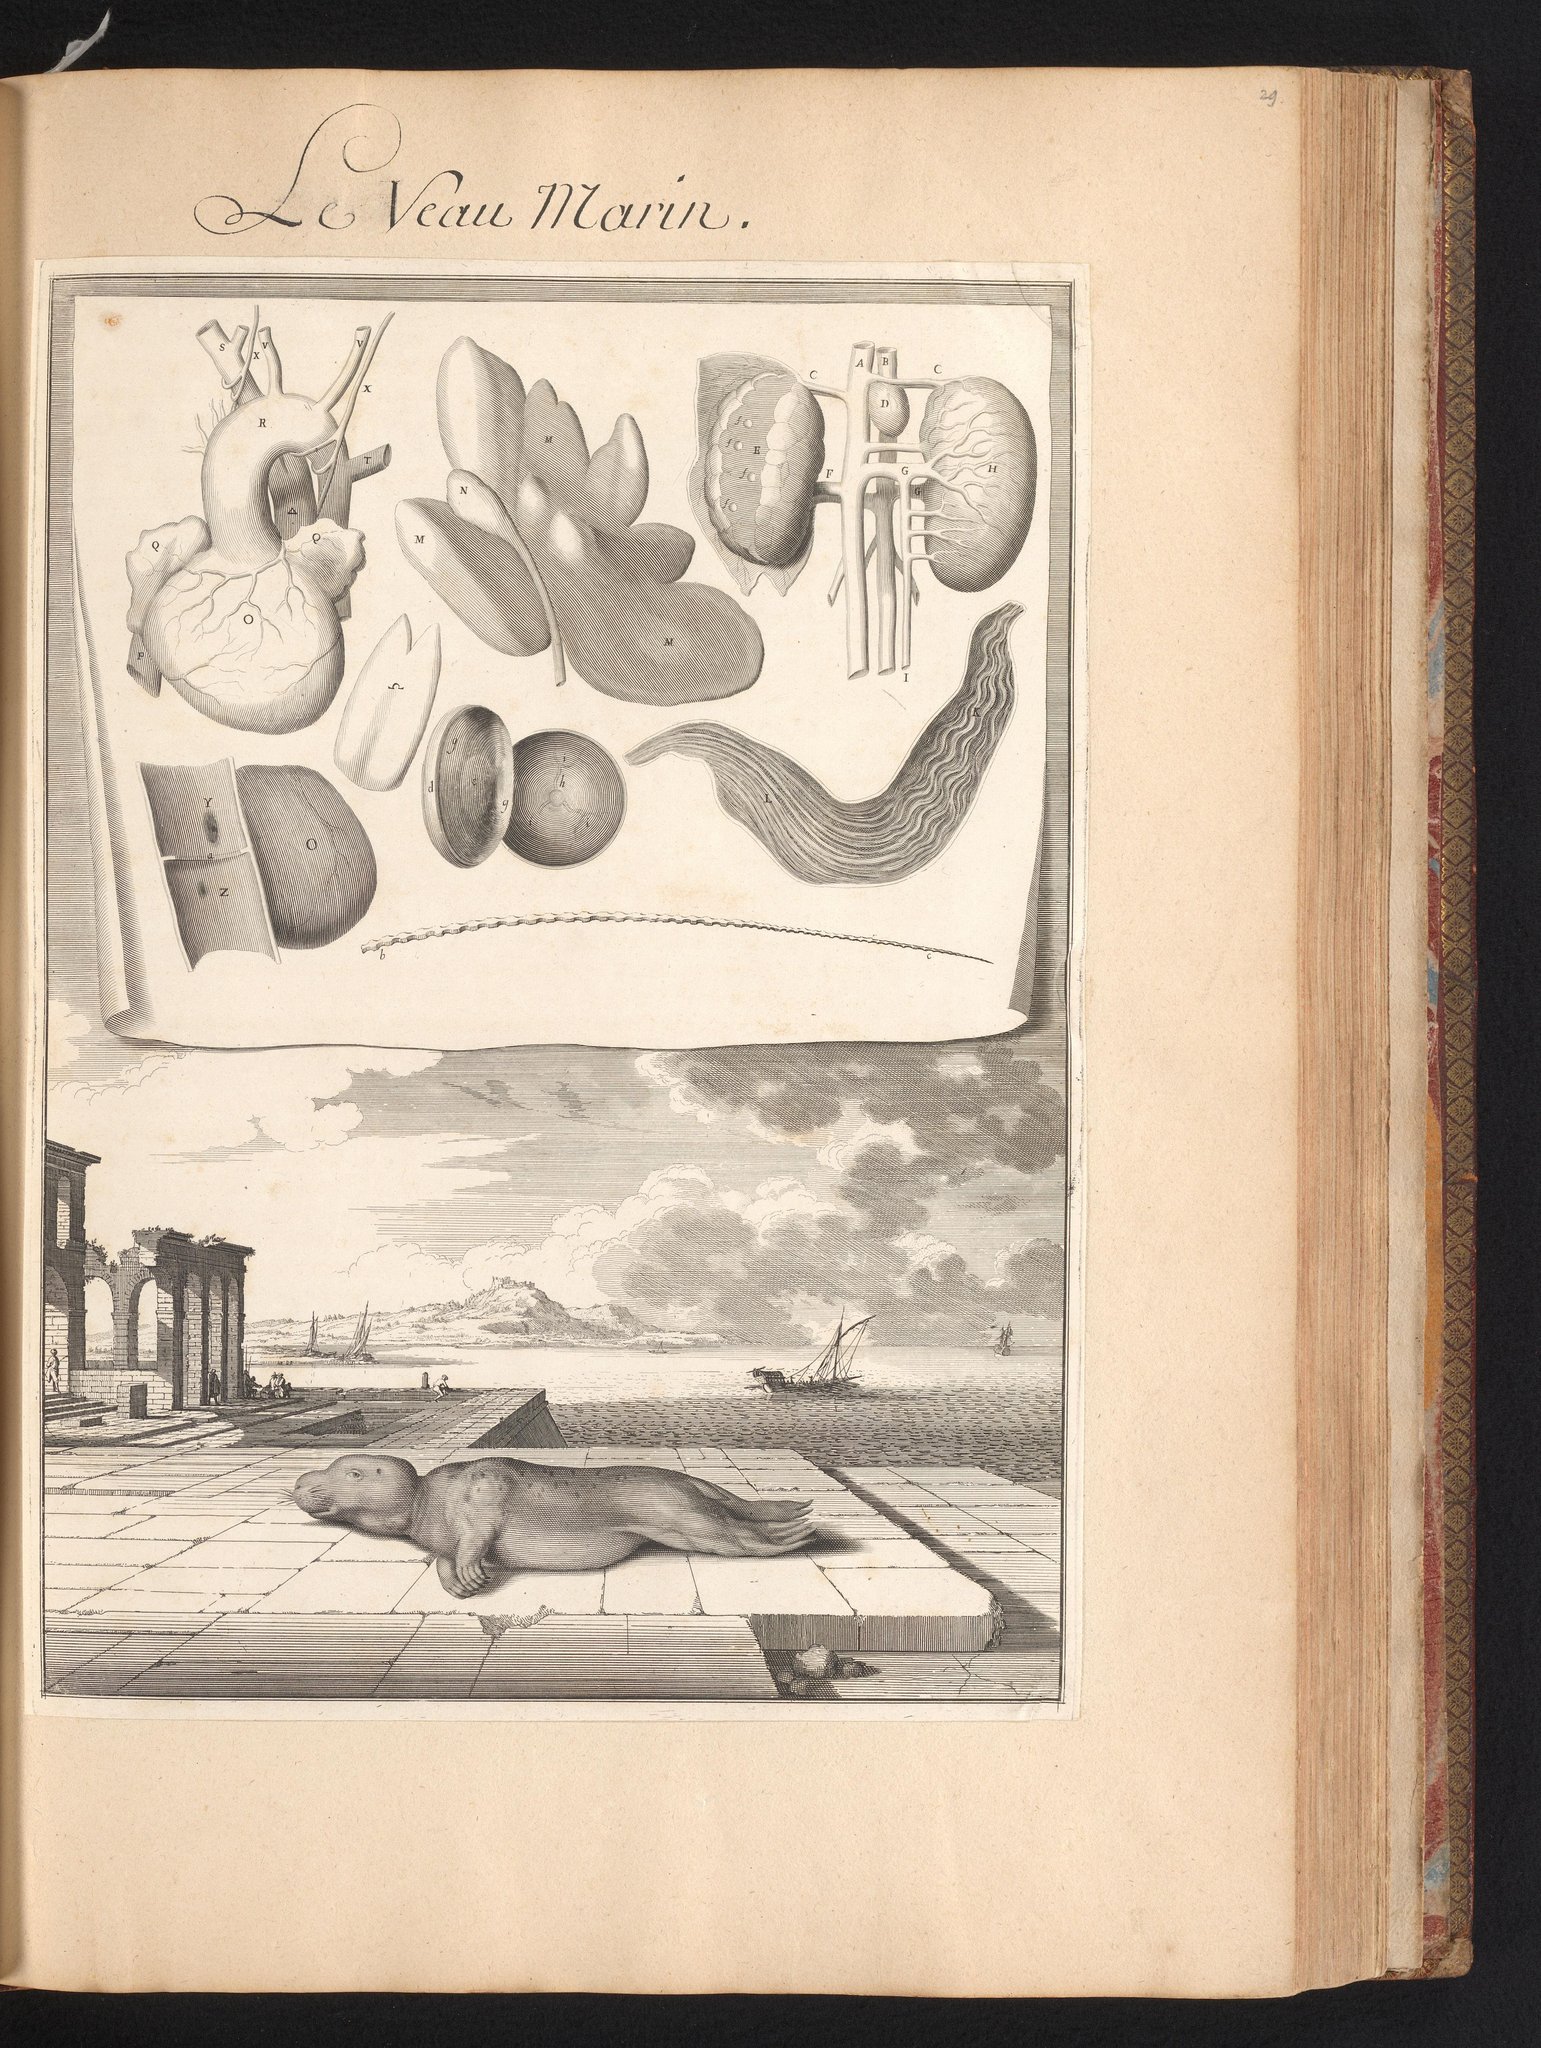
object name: album leaf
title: Zeehond (phoca vitulina) aan de kust met bovenaan op een blad de organen van het dier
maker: sébastien leclerc (i)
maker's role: print maker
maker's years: 1637-1714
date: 1676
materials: ink, paper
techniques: engraving, etching, pen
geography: paris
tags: dissection, animals (+ anatomy of animals), swimming mammals: seal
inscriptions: inscription: ‘Le veau Marin.’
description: Prent uit: Perrault, Claude. Mémoires pour servir à l'histoire naturelle des animaux. Dressez par M. Perrault de l'Académie Royale des Sciences (...). Parijs: Imprimerie Royale, 1676.